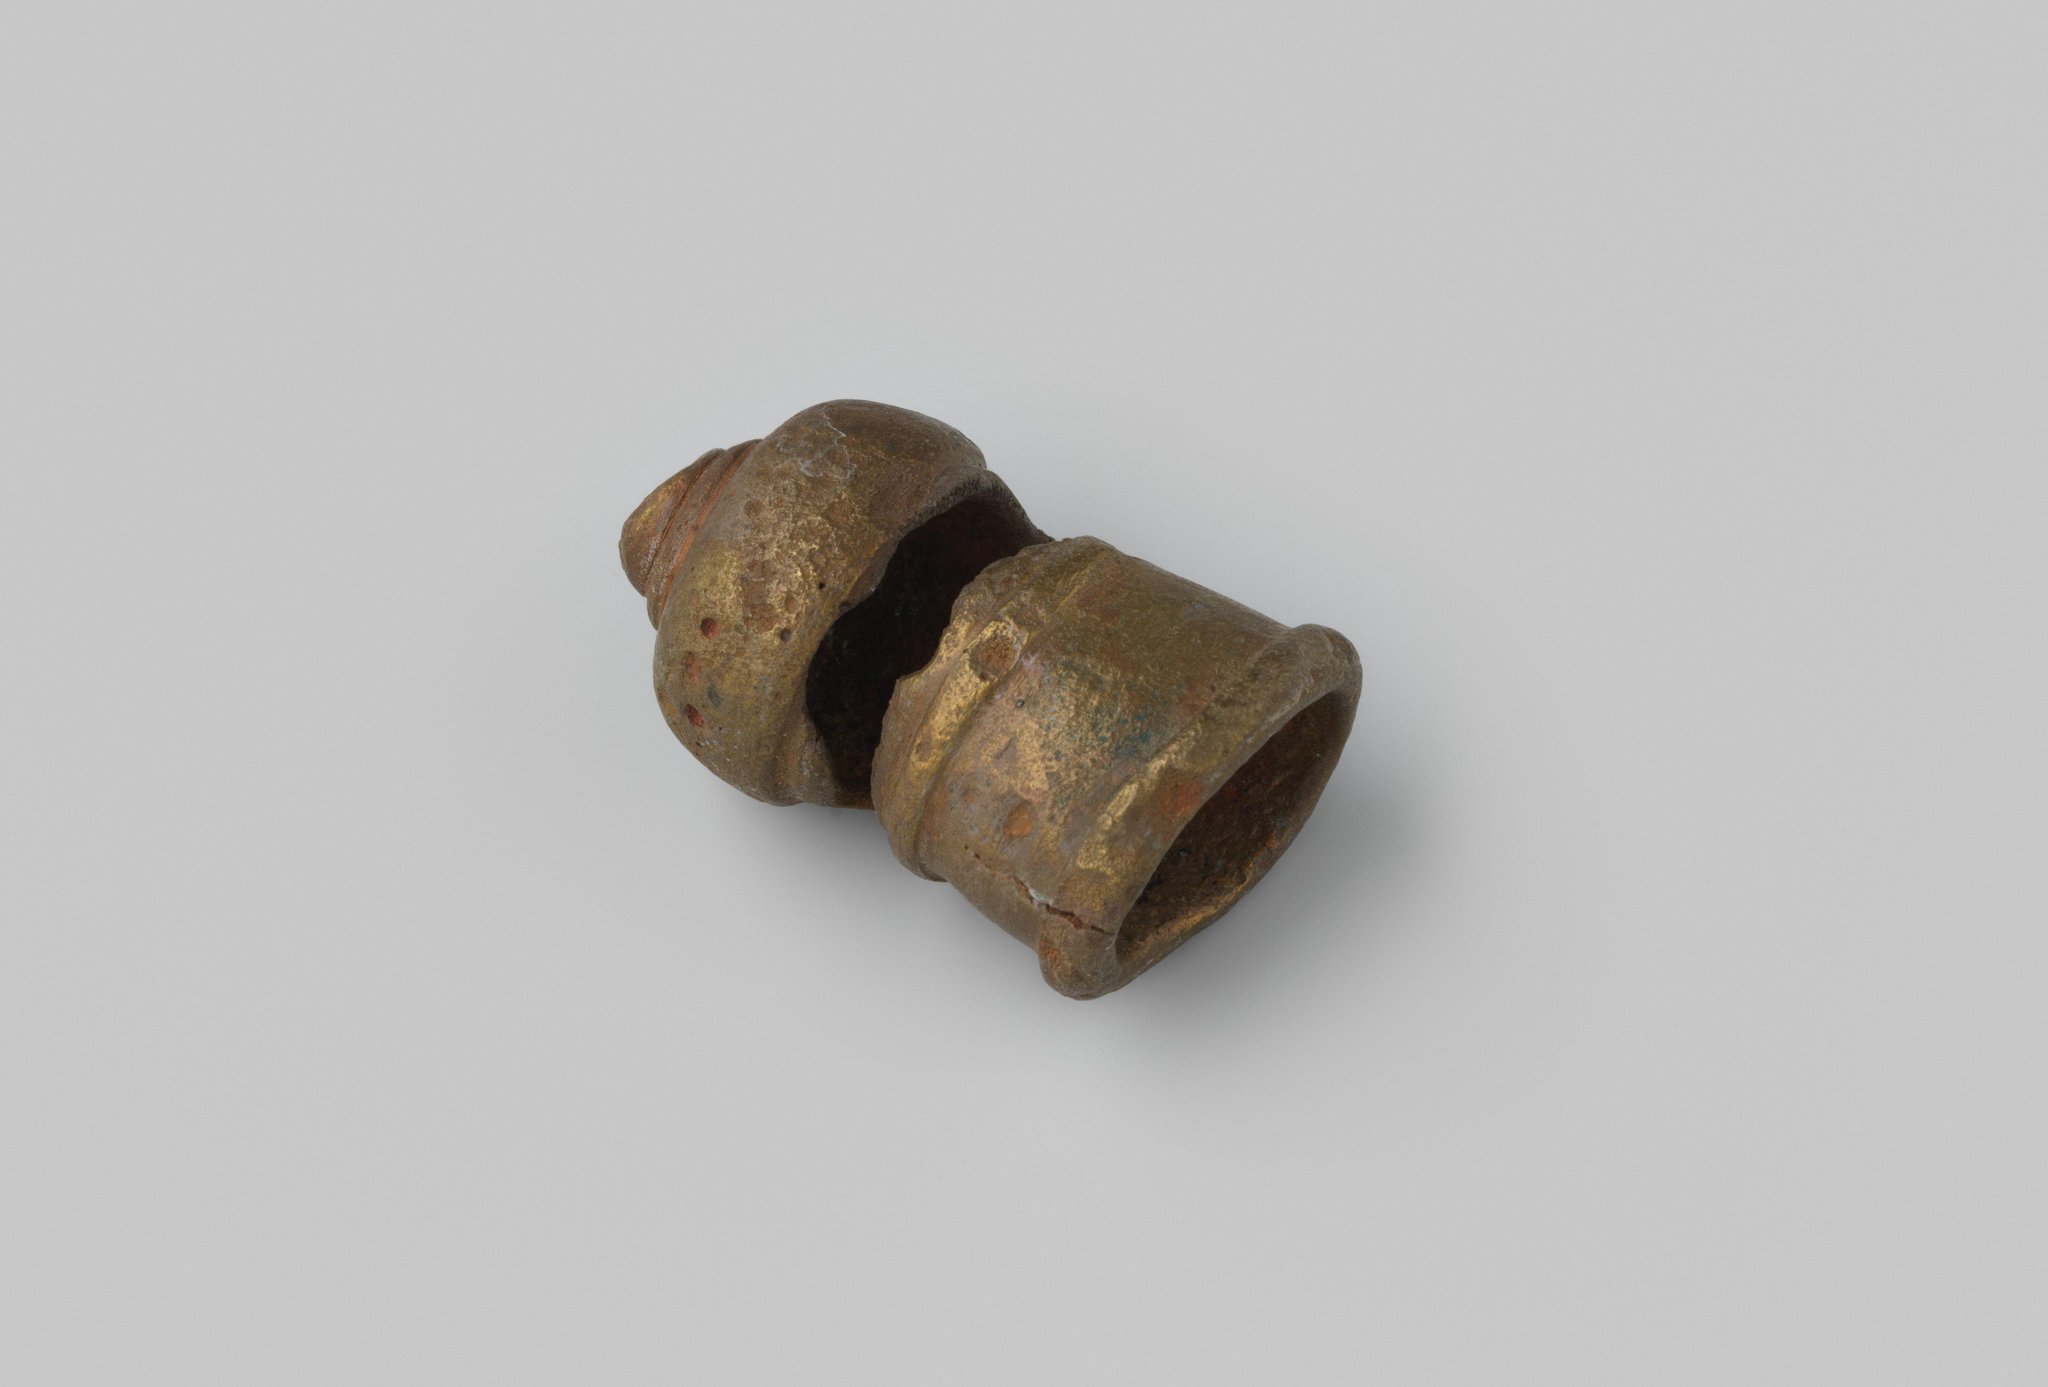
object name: clamp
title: Fragment klem afkomstig uit het wrak van de Oost-Indiëvaarder Hollandia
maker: Anonymous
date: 1700-1743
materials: copper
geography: netherlands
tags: verenigde oostindische compagnie, hollandia (schip)